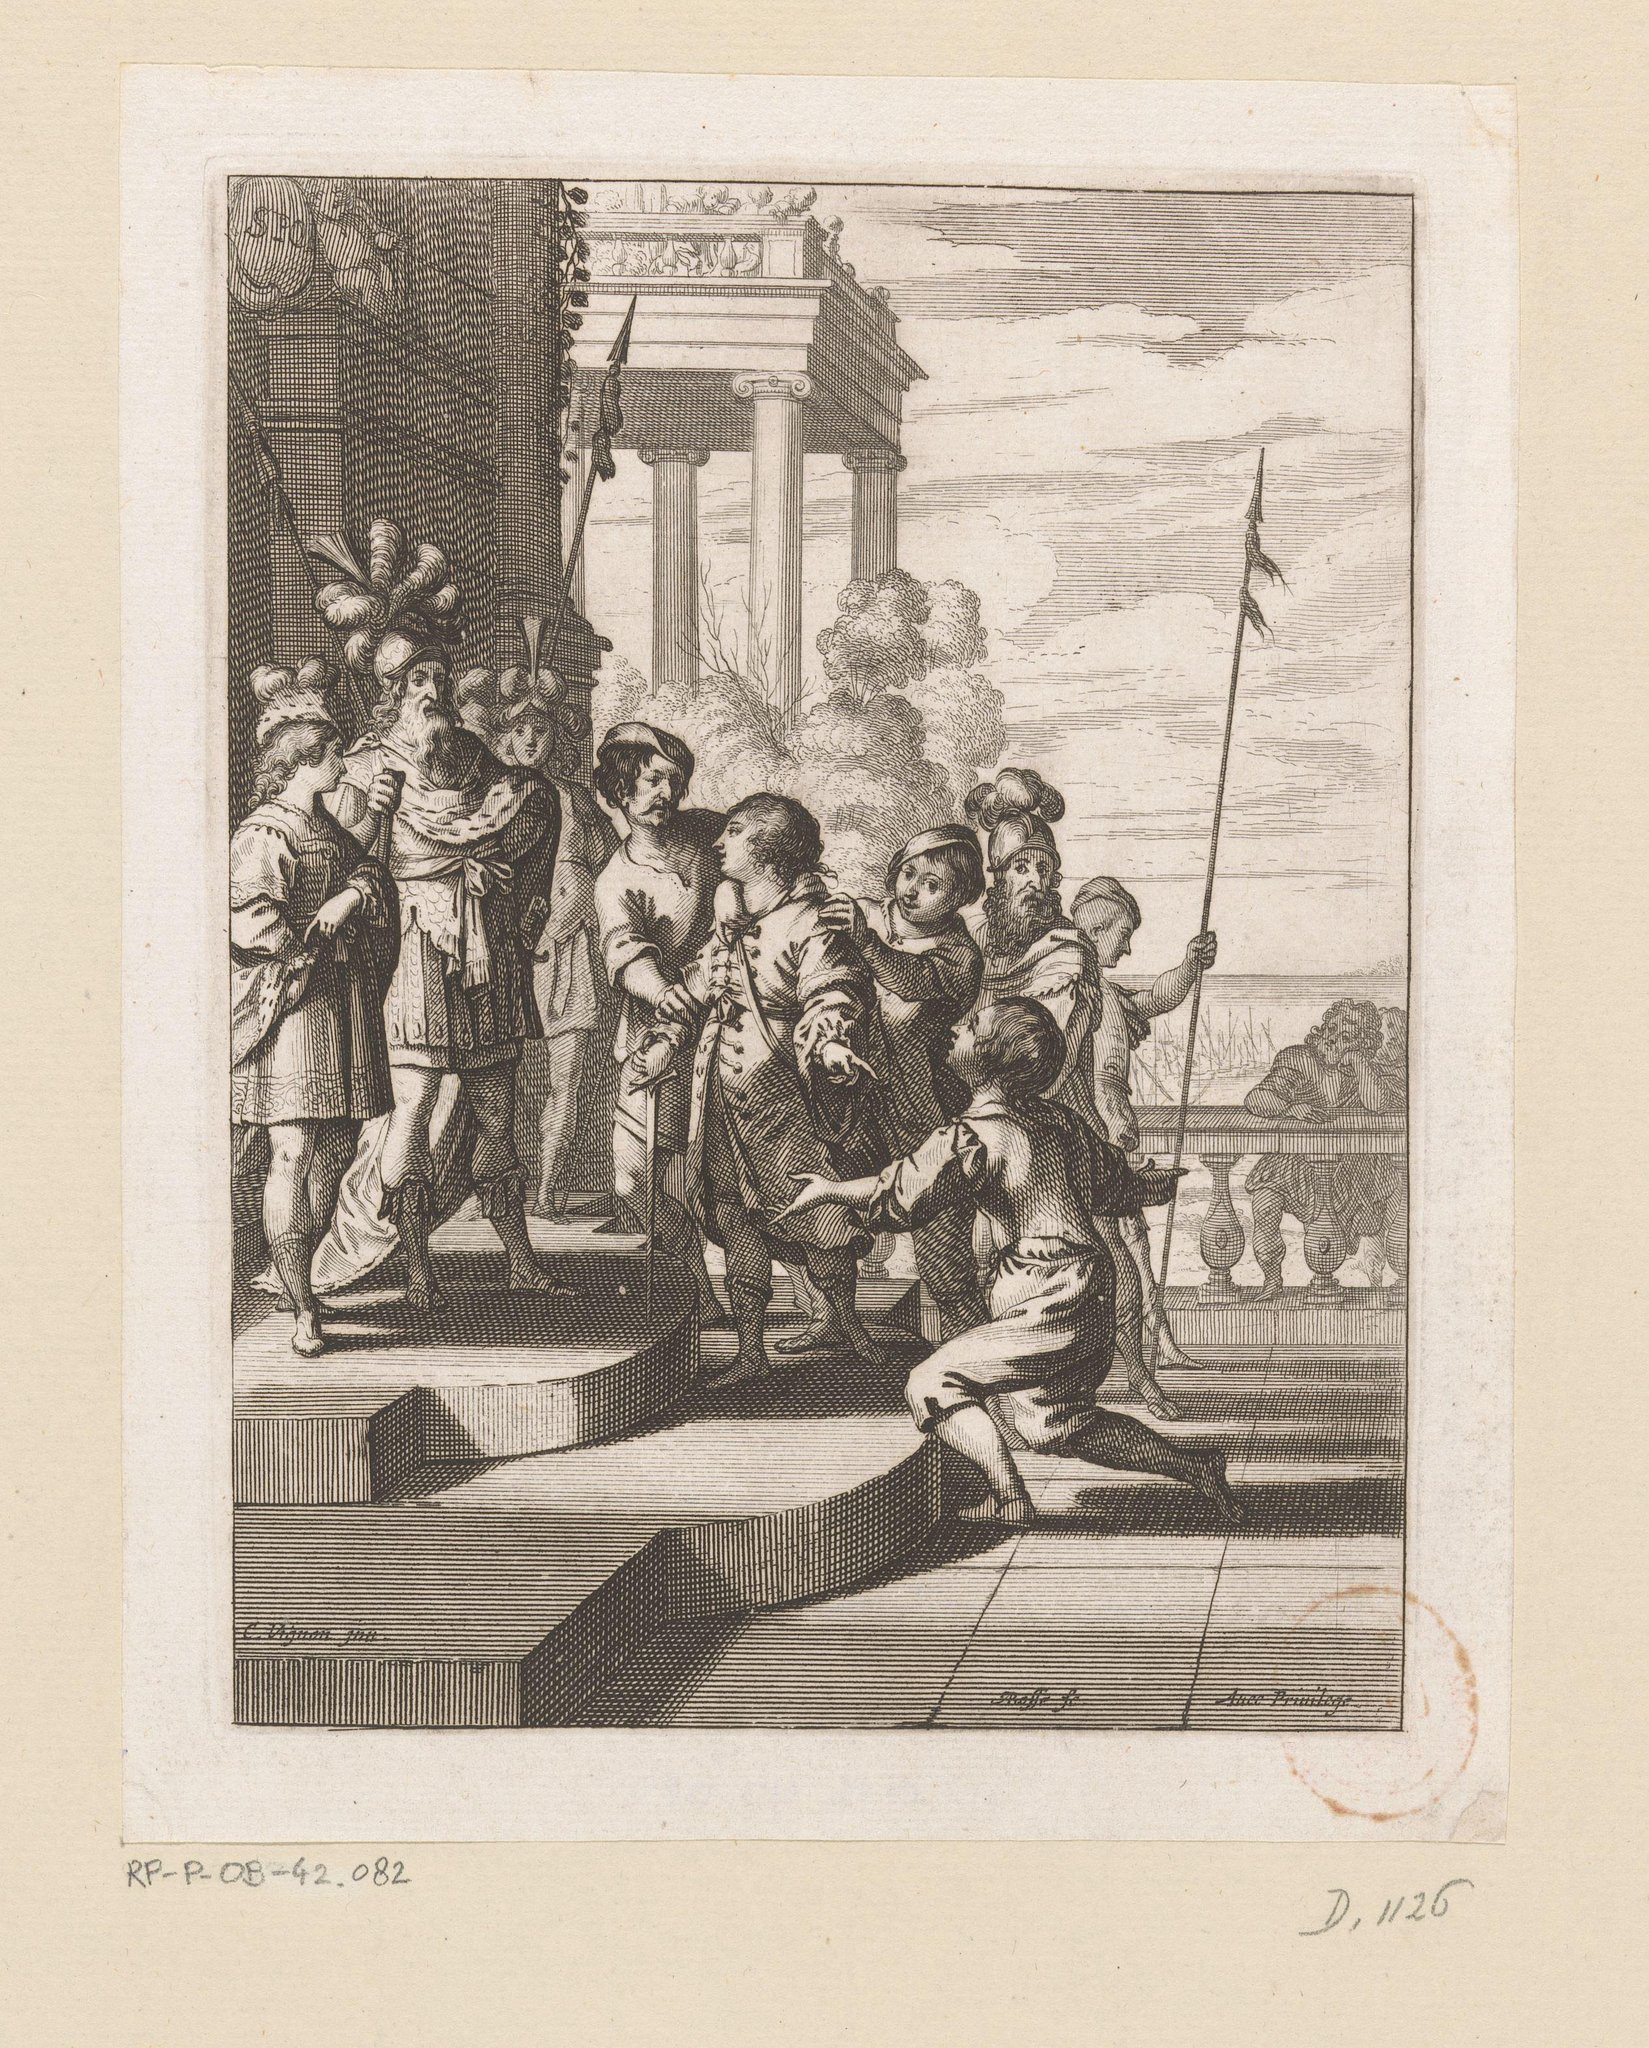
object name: book illustration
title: Epicharis voor Trébace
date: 1639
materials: paper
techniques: engraving, etching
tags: kneeling figure, king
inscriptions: collector's mark: Lugt 240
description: Prent uit: Desmarets de Saint-Sorlin, Jean. L'Ariane. Parijs: Guillemot, Matthieu, 1639.